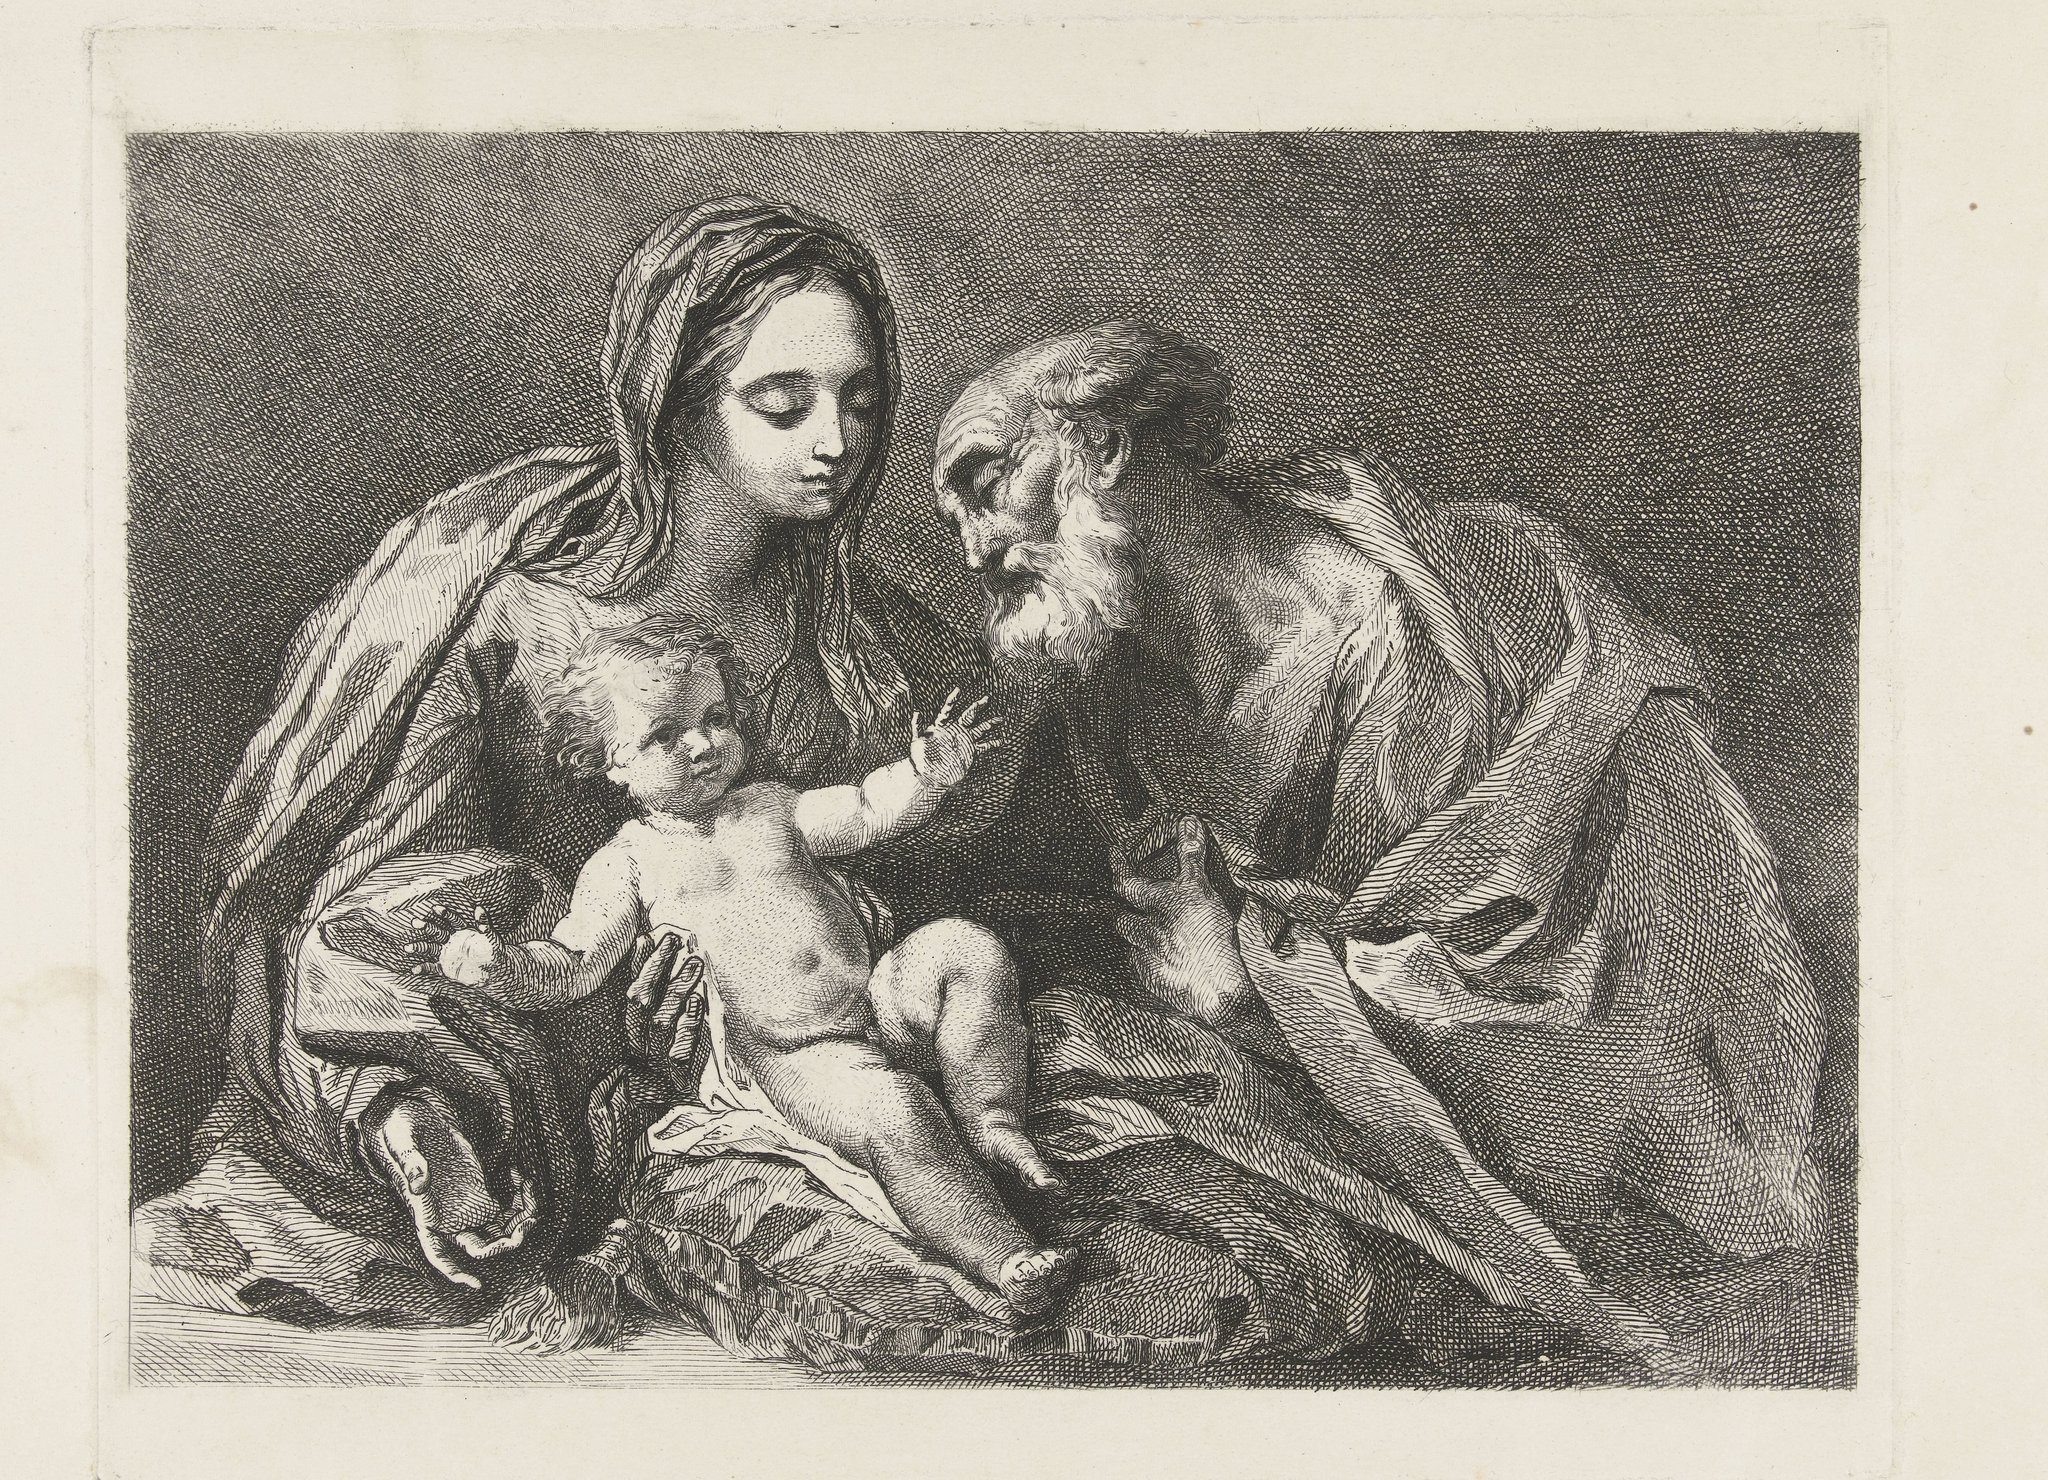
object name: print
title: De Heilige Familie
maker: petrus johannes arendzen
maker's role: draughtsman, print maker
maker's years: 1846-1932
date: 1864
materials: paper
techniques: engraving, etching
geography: netherlands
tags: holy family (alone), 'trinitas terrestris'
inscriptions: inscription: ‘PJ Arendzen 1. April 1864’